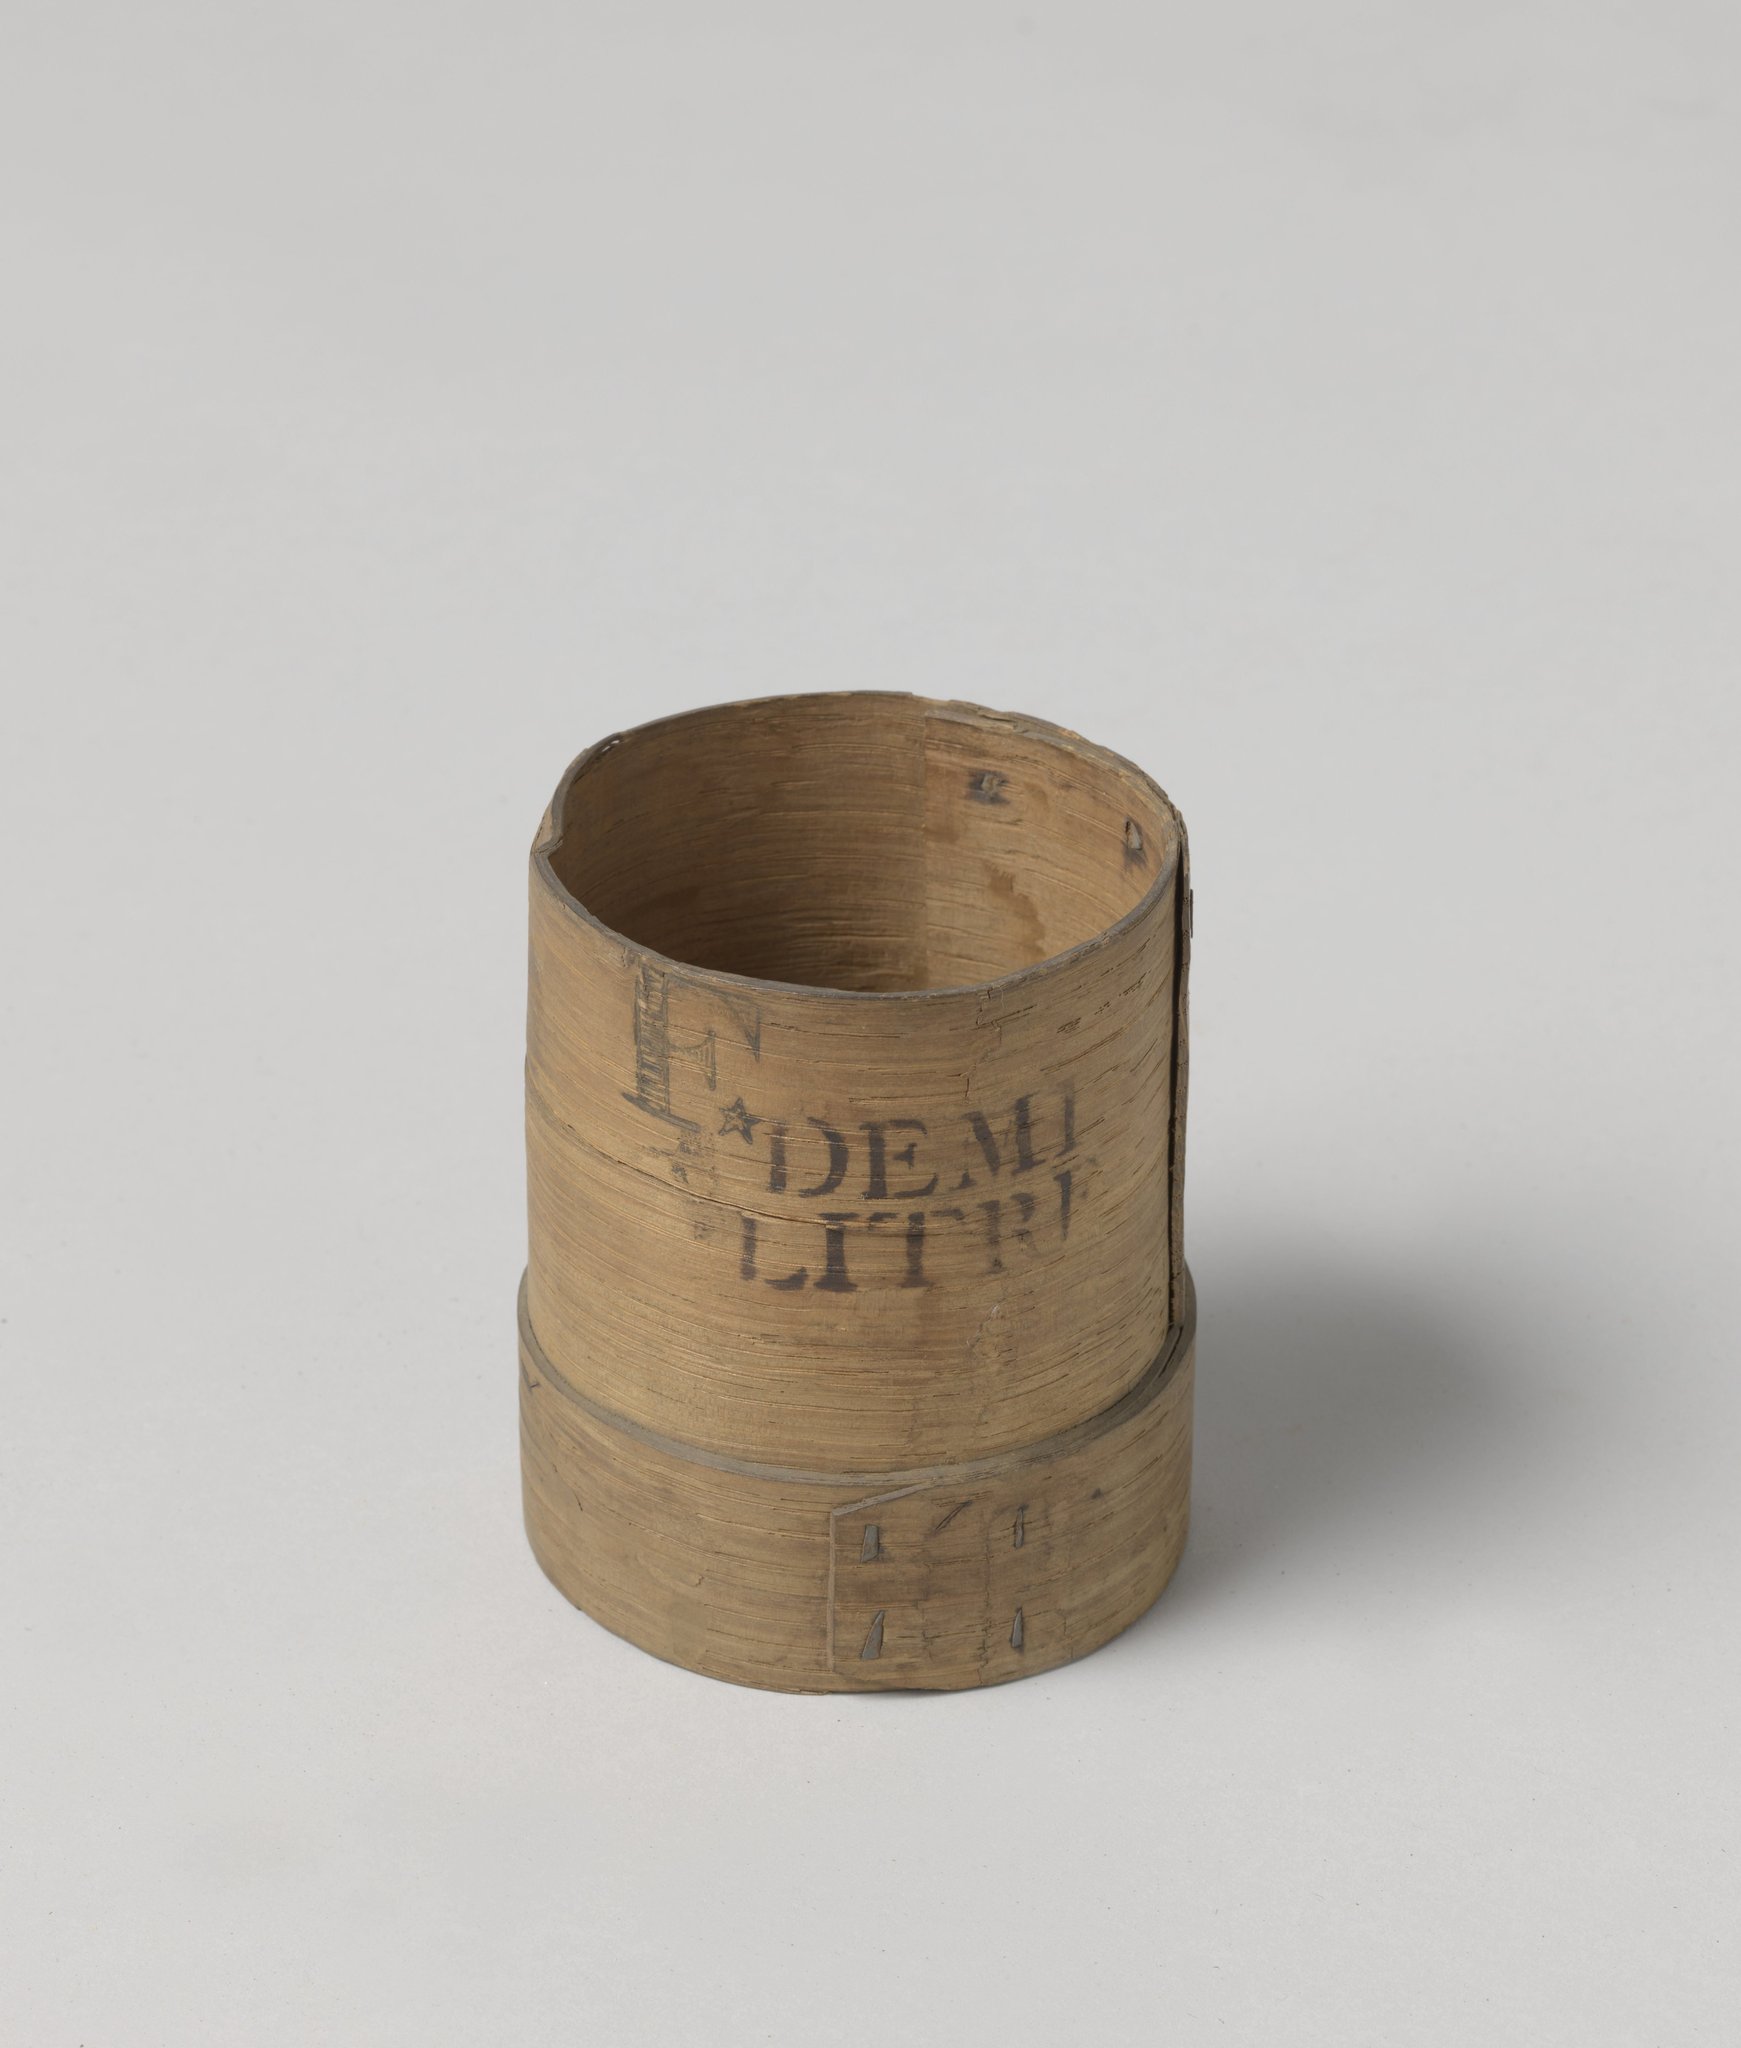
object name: inhoudsmaat droge waren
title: Inhoudsmaat van 1/2 liter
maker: Anonymous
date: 1825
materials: wood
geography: netherlands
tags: netherlands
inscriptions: coat of arms, number: ‘34’, mark: ‘F*’, seal: ‘T.F. Wolschot’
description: Spanen inhoudsmaat van 1/2 deciliter (demi litre) met houten bodemrand. Aan de onderzijde v.z.v. oranje lakzegel met opschrift. V.z.v. merken en stempels.